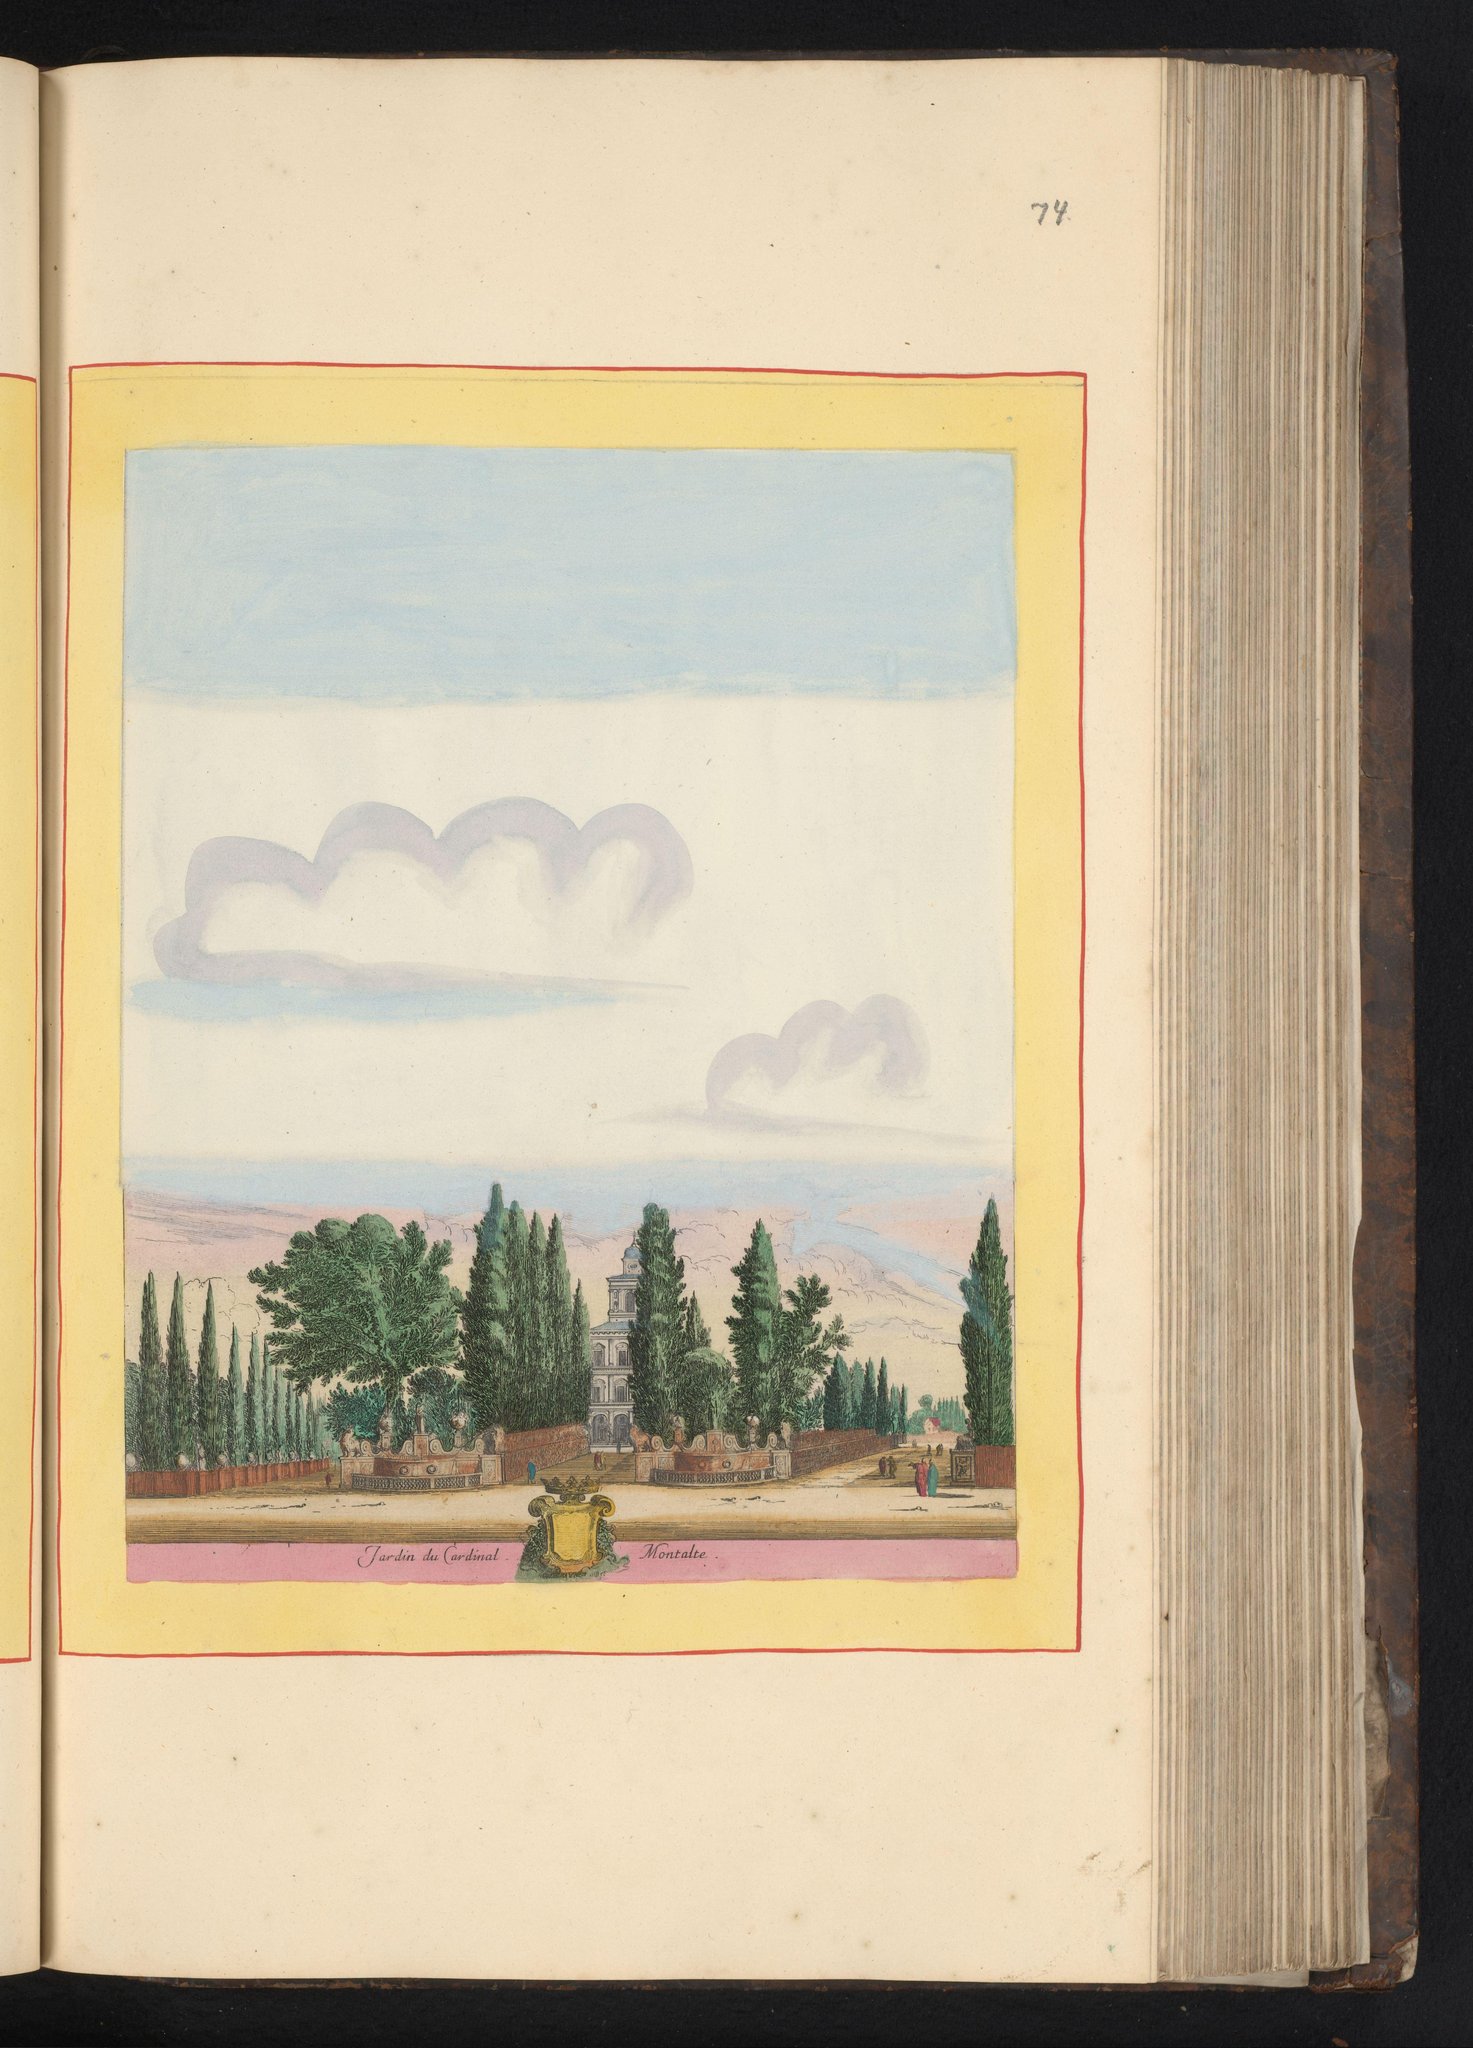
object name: print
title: Jardin du cardinal Montalte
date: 1631-1691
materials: paper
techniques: colour, etching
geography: the hague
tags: city-view, and landscape with man-made constructions, garden, villa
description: Prent maakt deel uit van een reeks van 9 prenten met gezichten op Rome en omgeving. De prent is langs de bovenrand van de voorstelling afgescheurd. De voorstelling is aan de bovenzijde aangevuld met een geschilderde lucht.